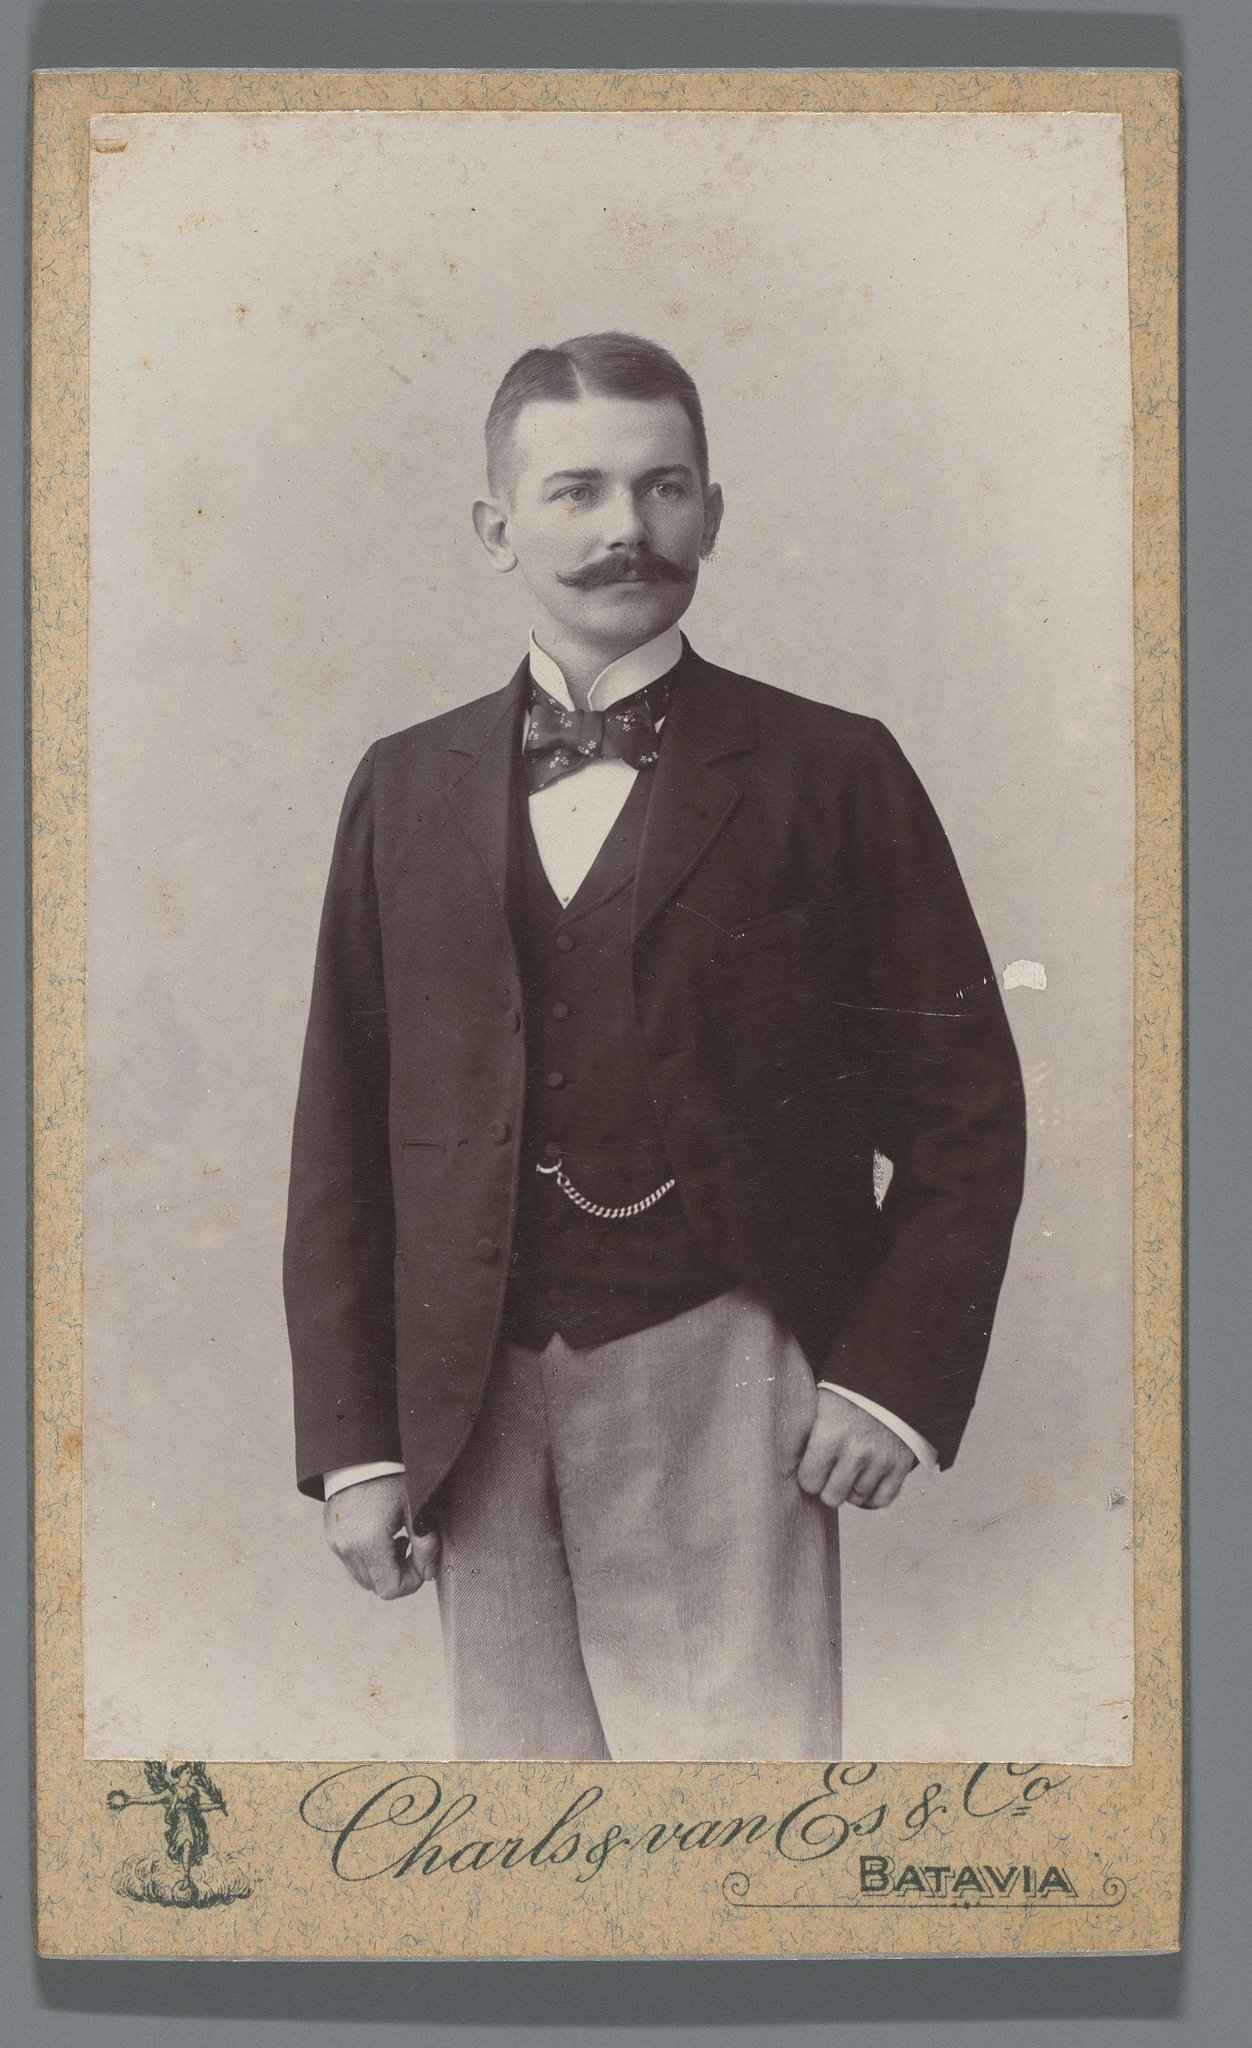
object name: carte de visite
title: Studioportret van Frans Alexander van den Berg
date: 1890-1910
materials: cardboard, photographic support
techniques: albumen print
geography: batavia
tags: batavia, amsterdam, frans alexander van den berg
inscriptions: name: ‘CHARLS & VAN ES & Co / BATAVIA’, name: ‘Photografie / CHARLS & van ES & CO’, name: ‘frans v. d. Berg’